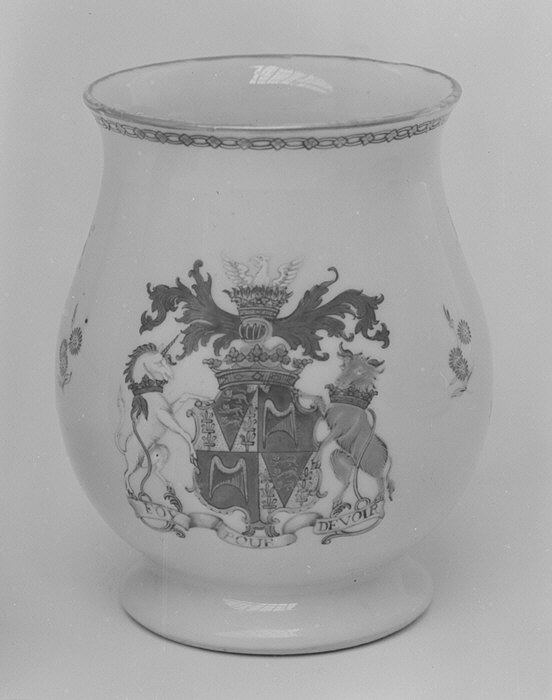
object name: mug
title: Mug (part of a service)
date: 1750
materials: hard paste porcelain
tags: animals,coat of arms